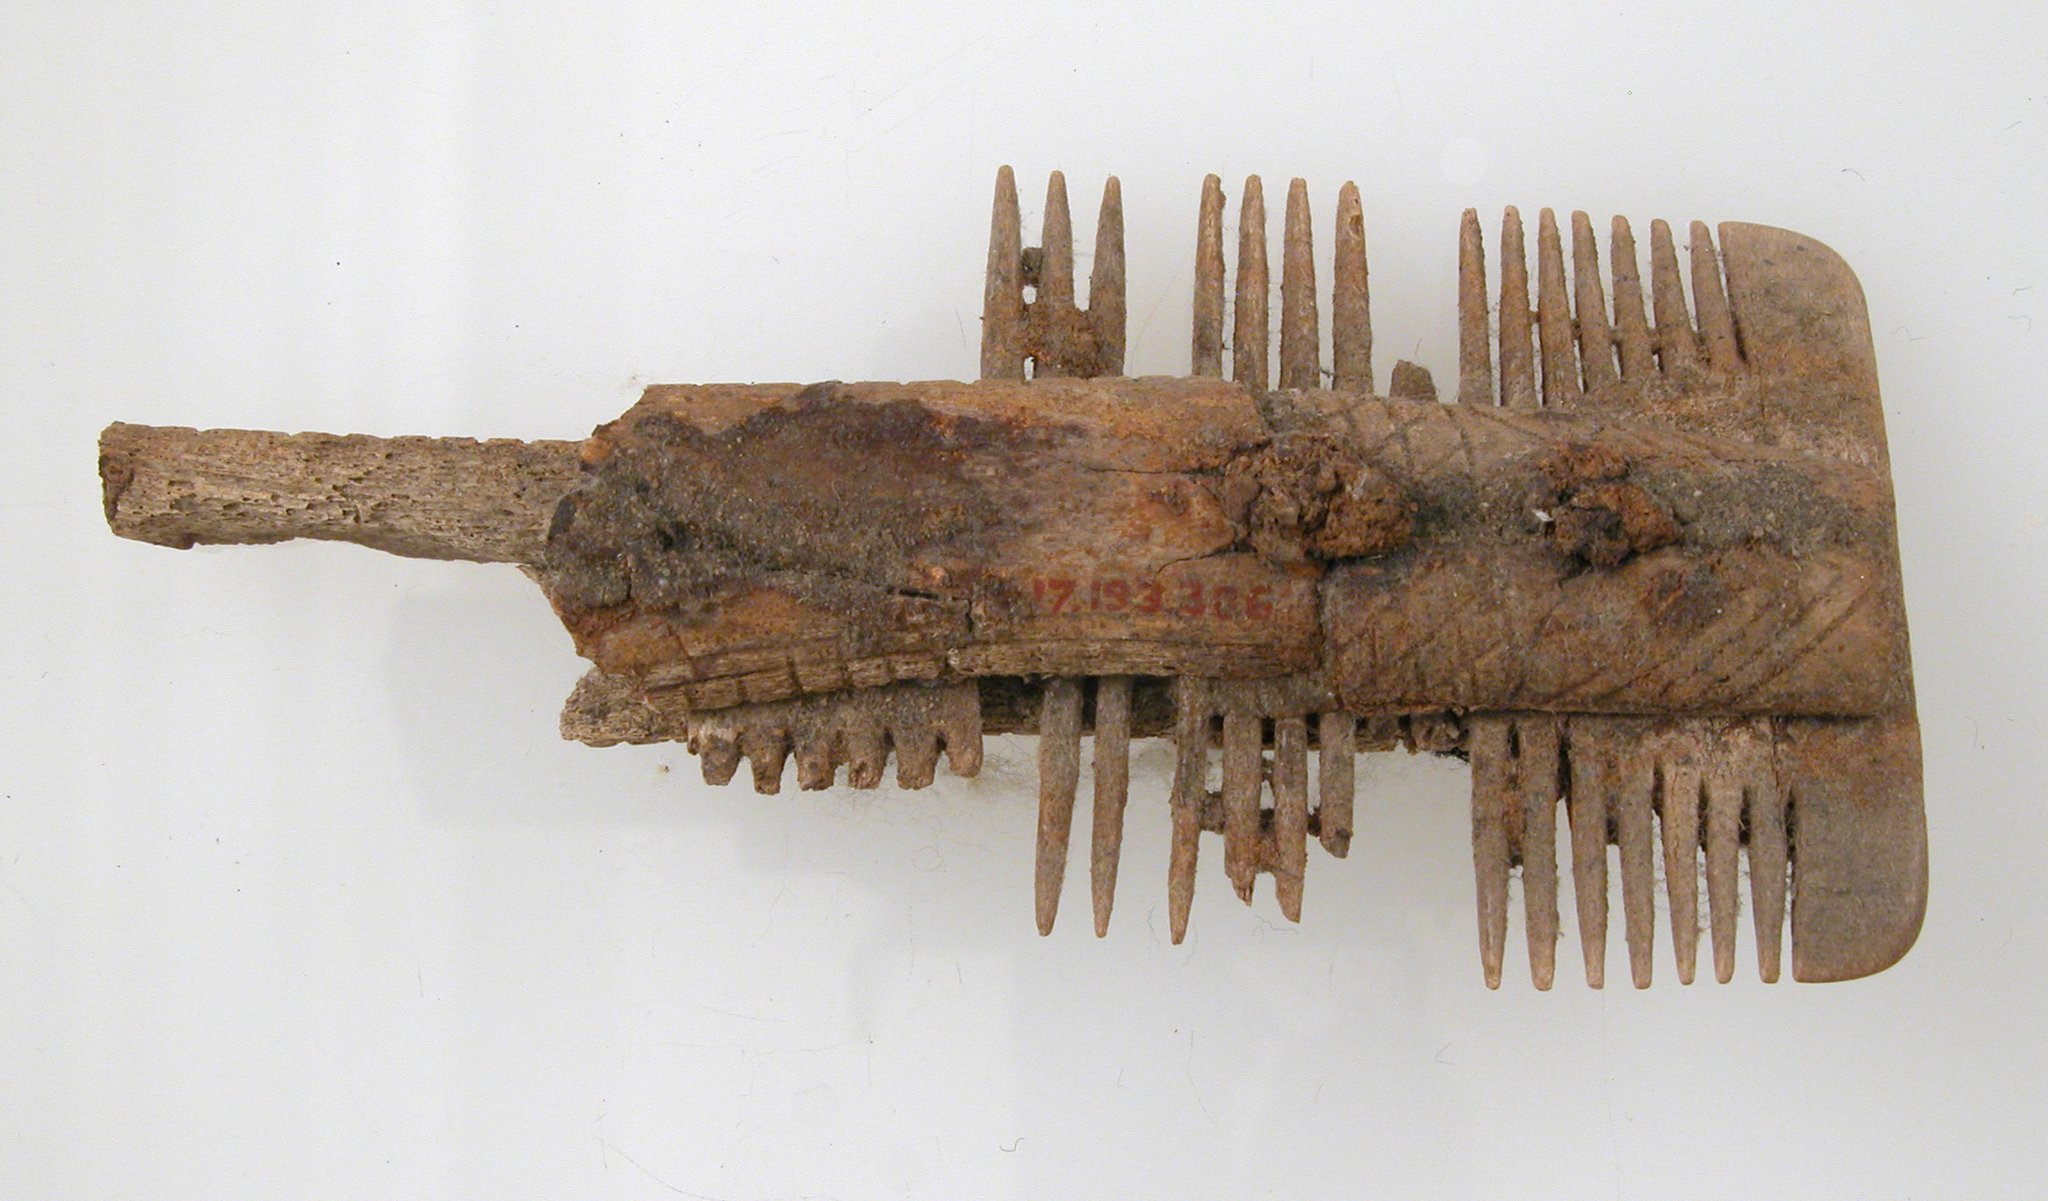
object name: comb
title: Double-Sided Comb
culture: frankish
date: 601-700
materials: bone, iron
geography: germany